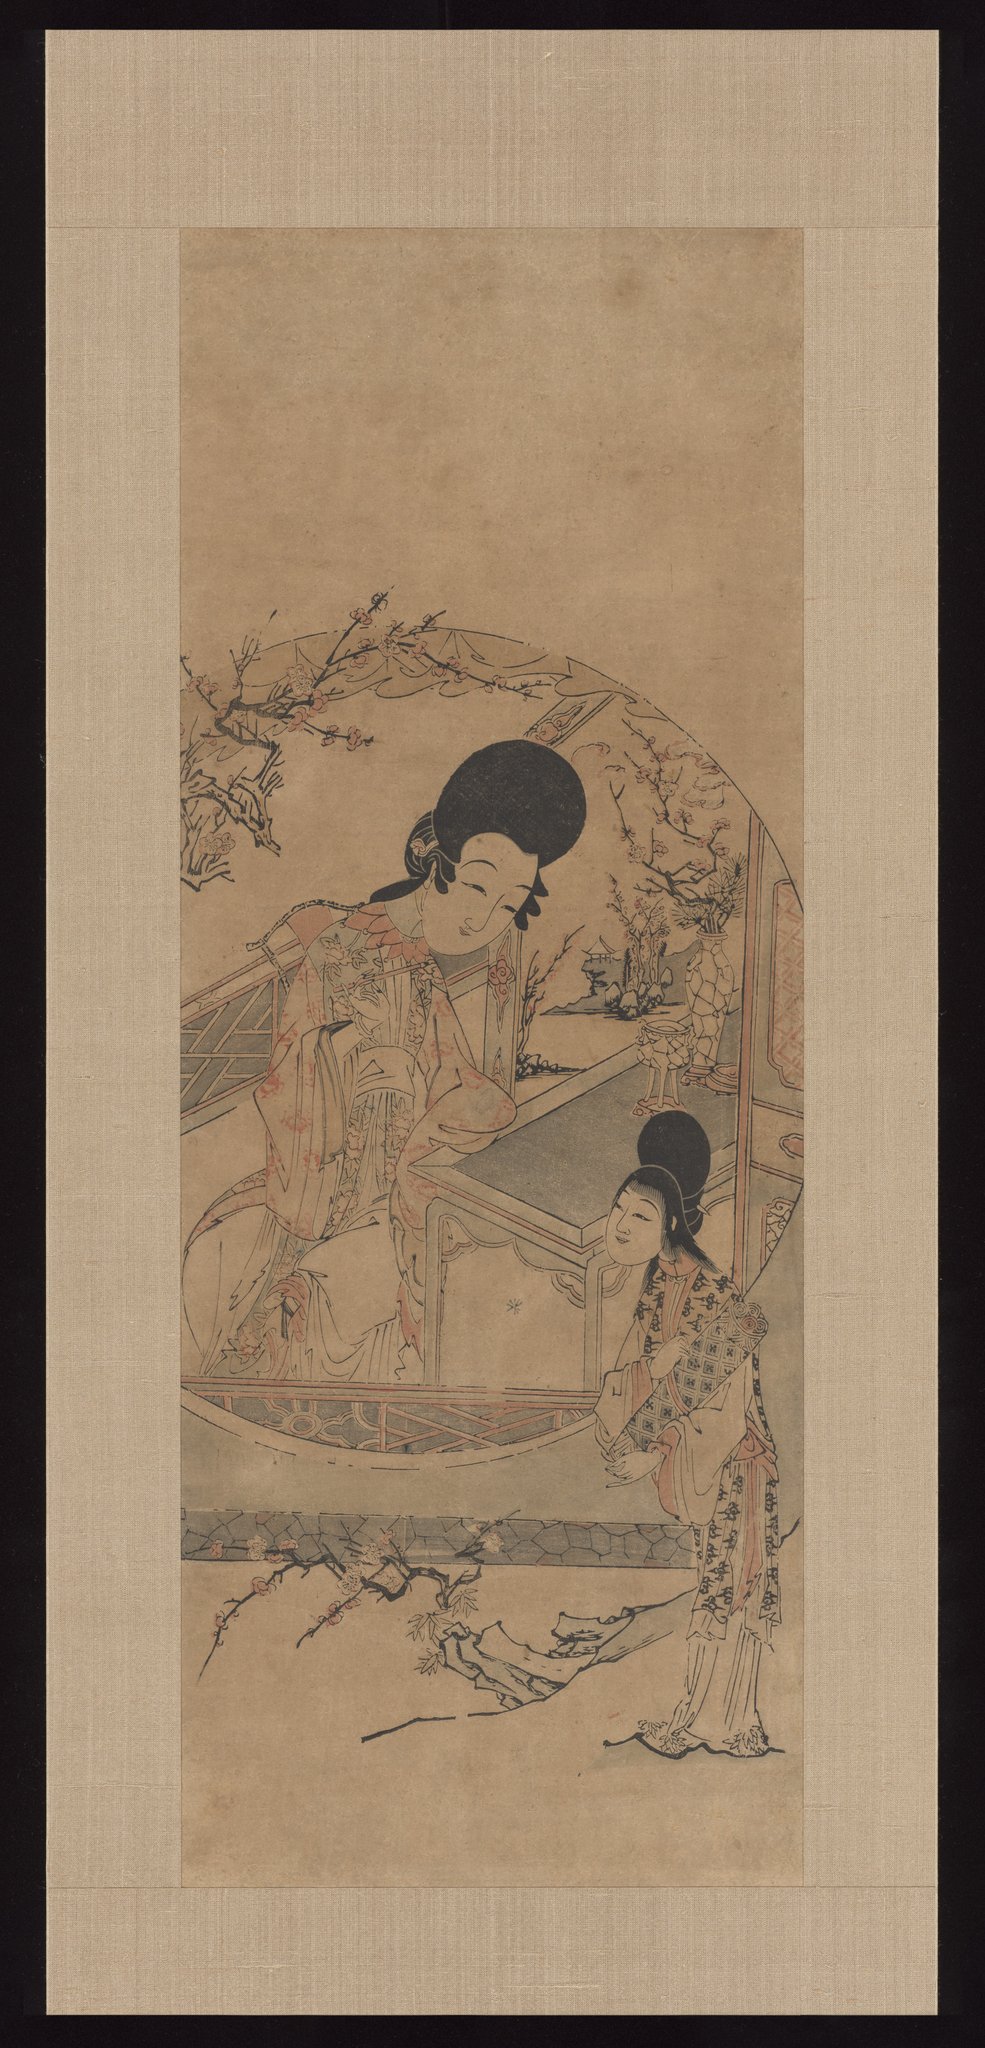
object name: print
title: Lady Holding a Brush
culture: chinese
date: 1662-1722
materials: ink, paper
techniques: hand coloring, woodblock print